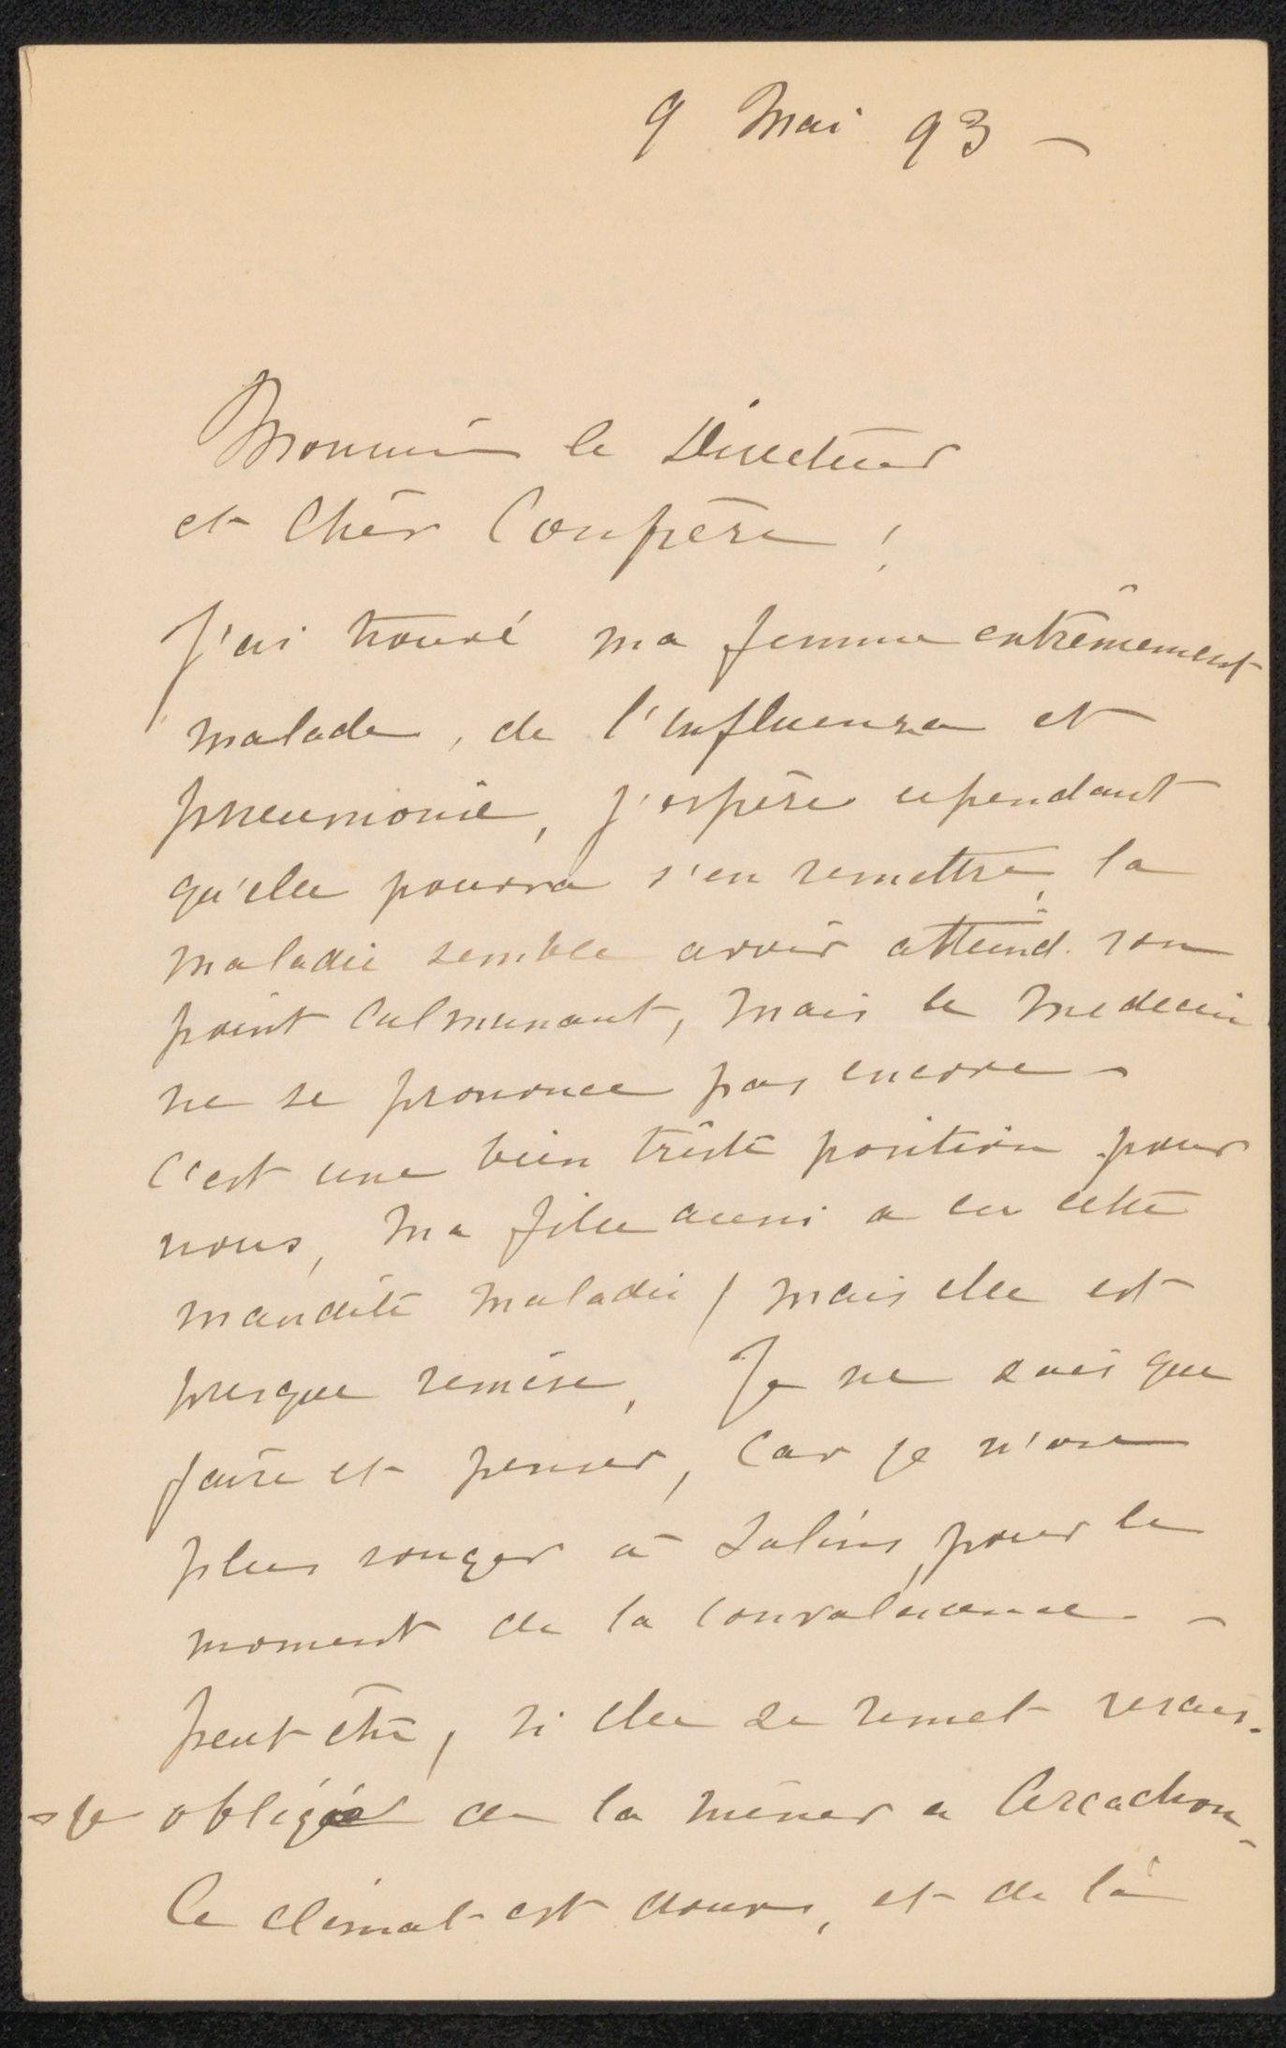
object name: letter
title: Brief aan August Allebé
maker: ferdinand leenhoff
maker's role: print maker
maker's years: 1841-1914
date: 1893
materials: ink, paper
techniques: pen, writing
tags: august allebé, family life, diseases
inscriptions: watermark